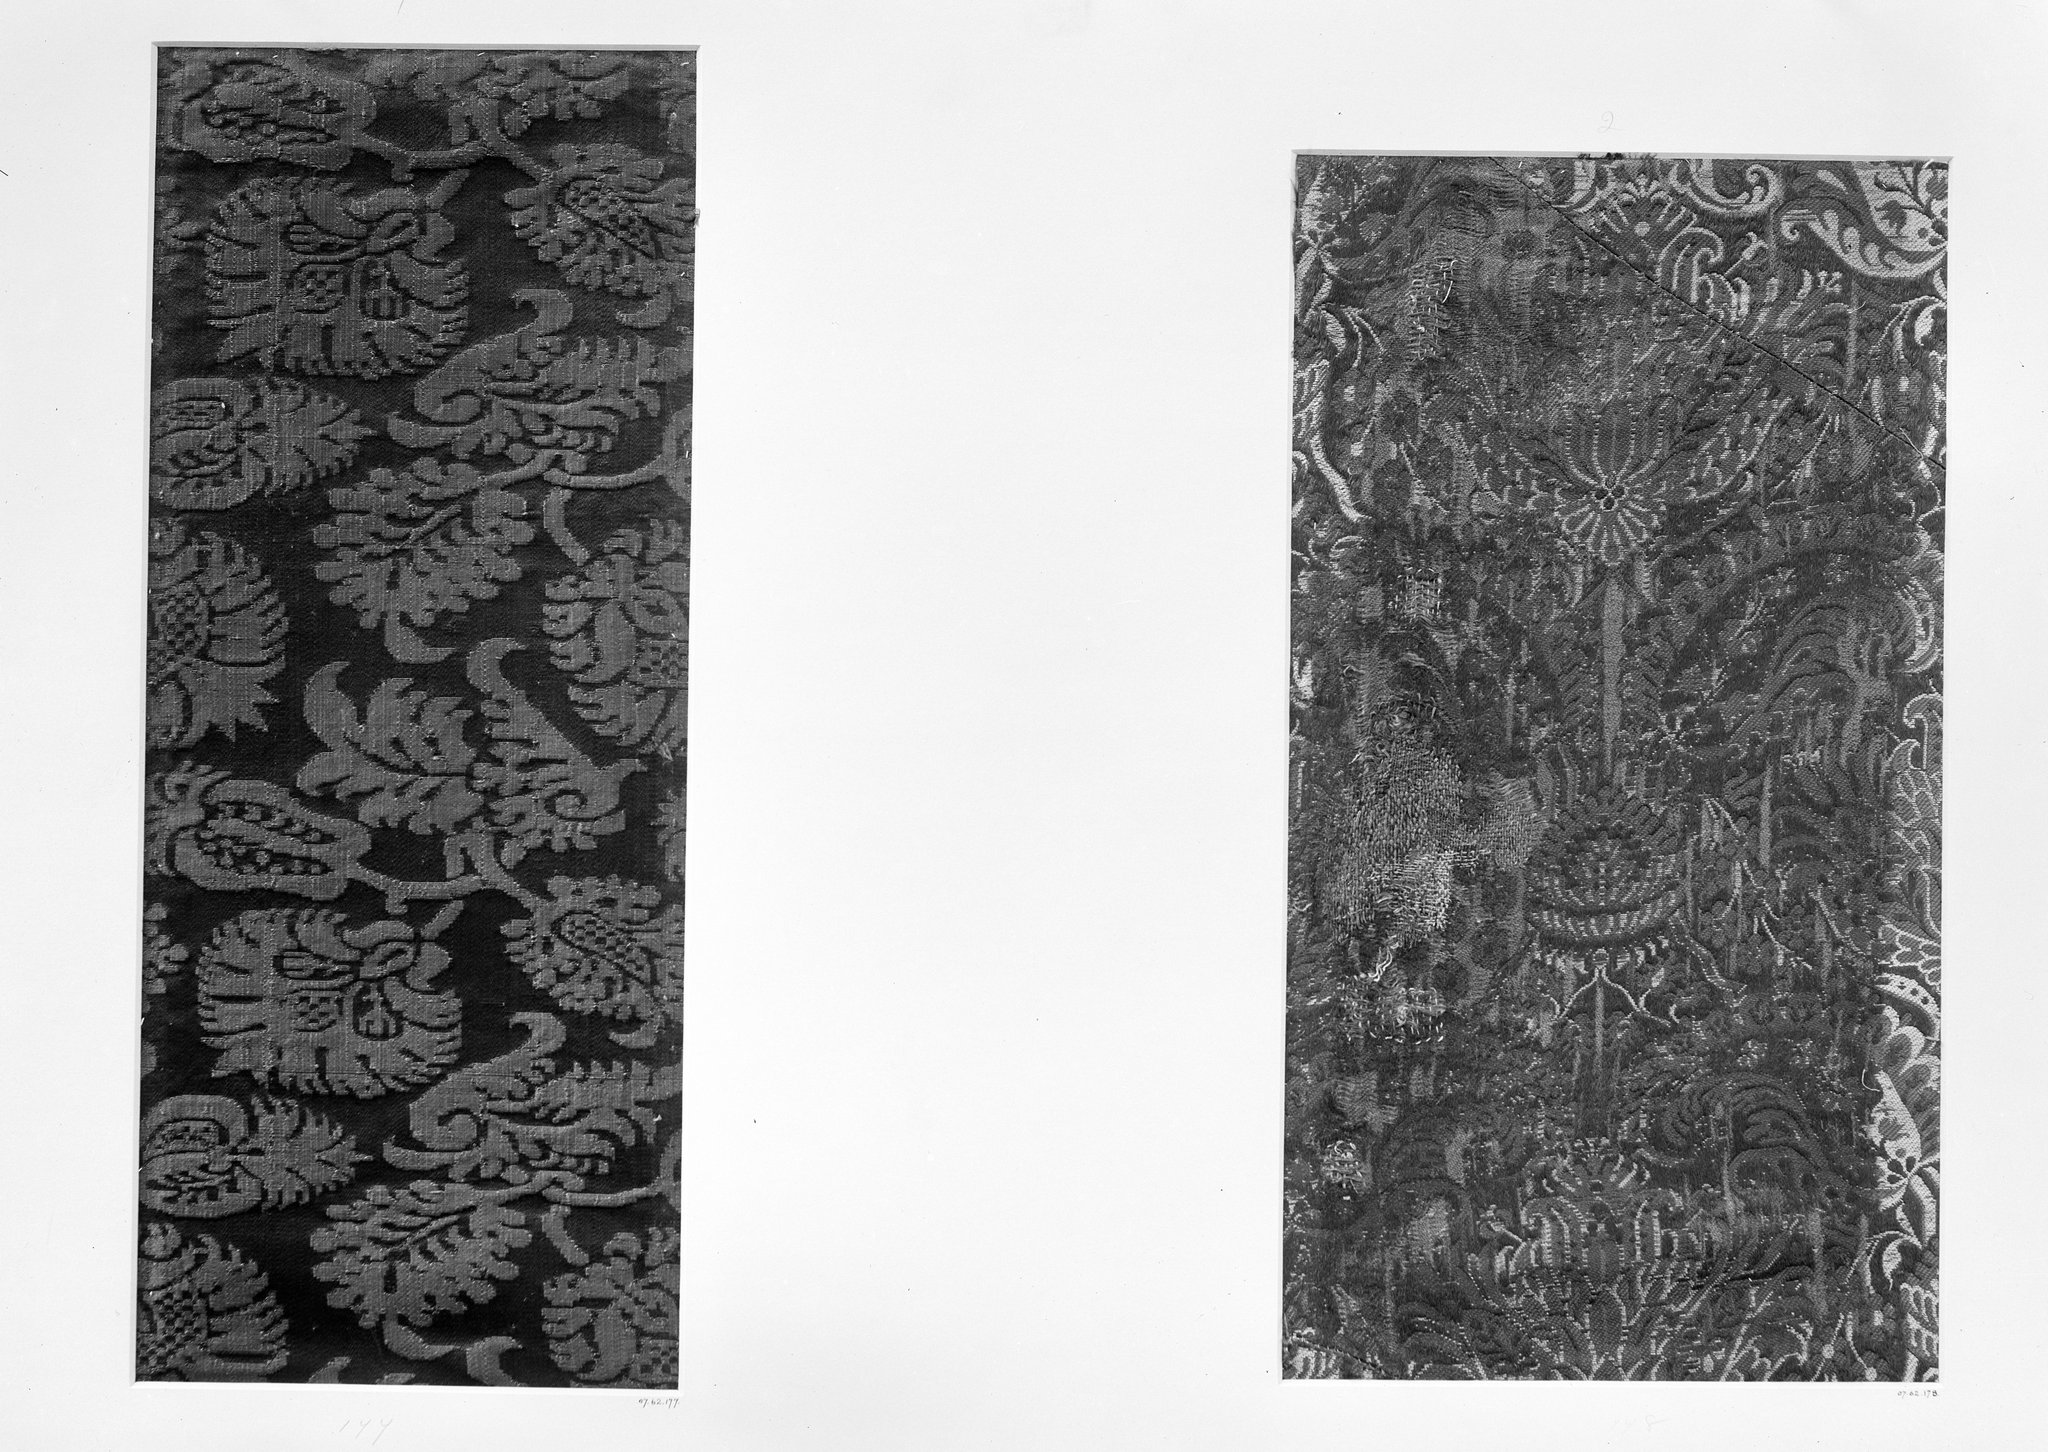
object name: piece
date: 1601-1700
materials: silk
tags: flowers,leaves